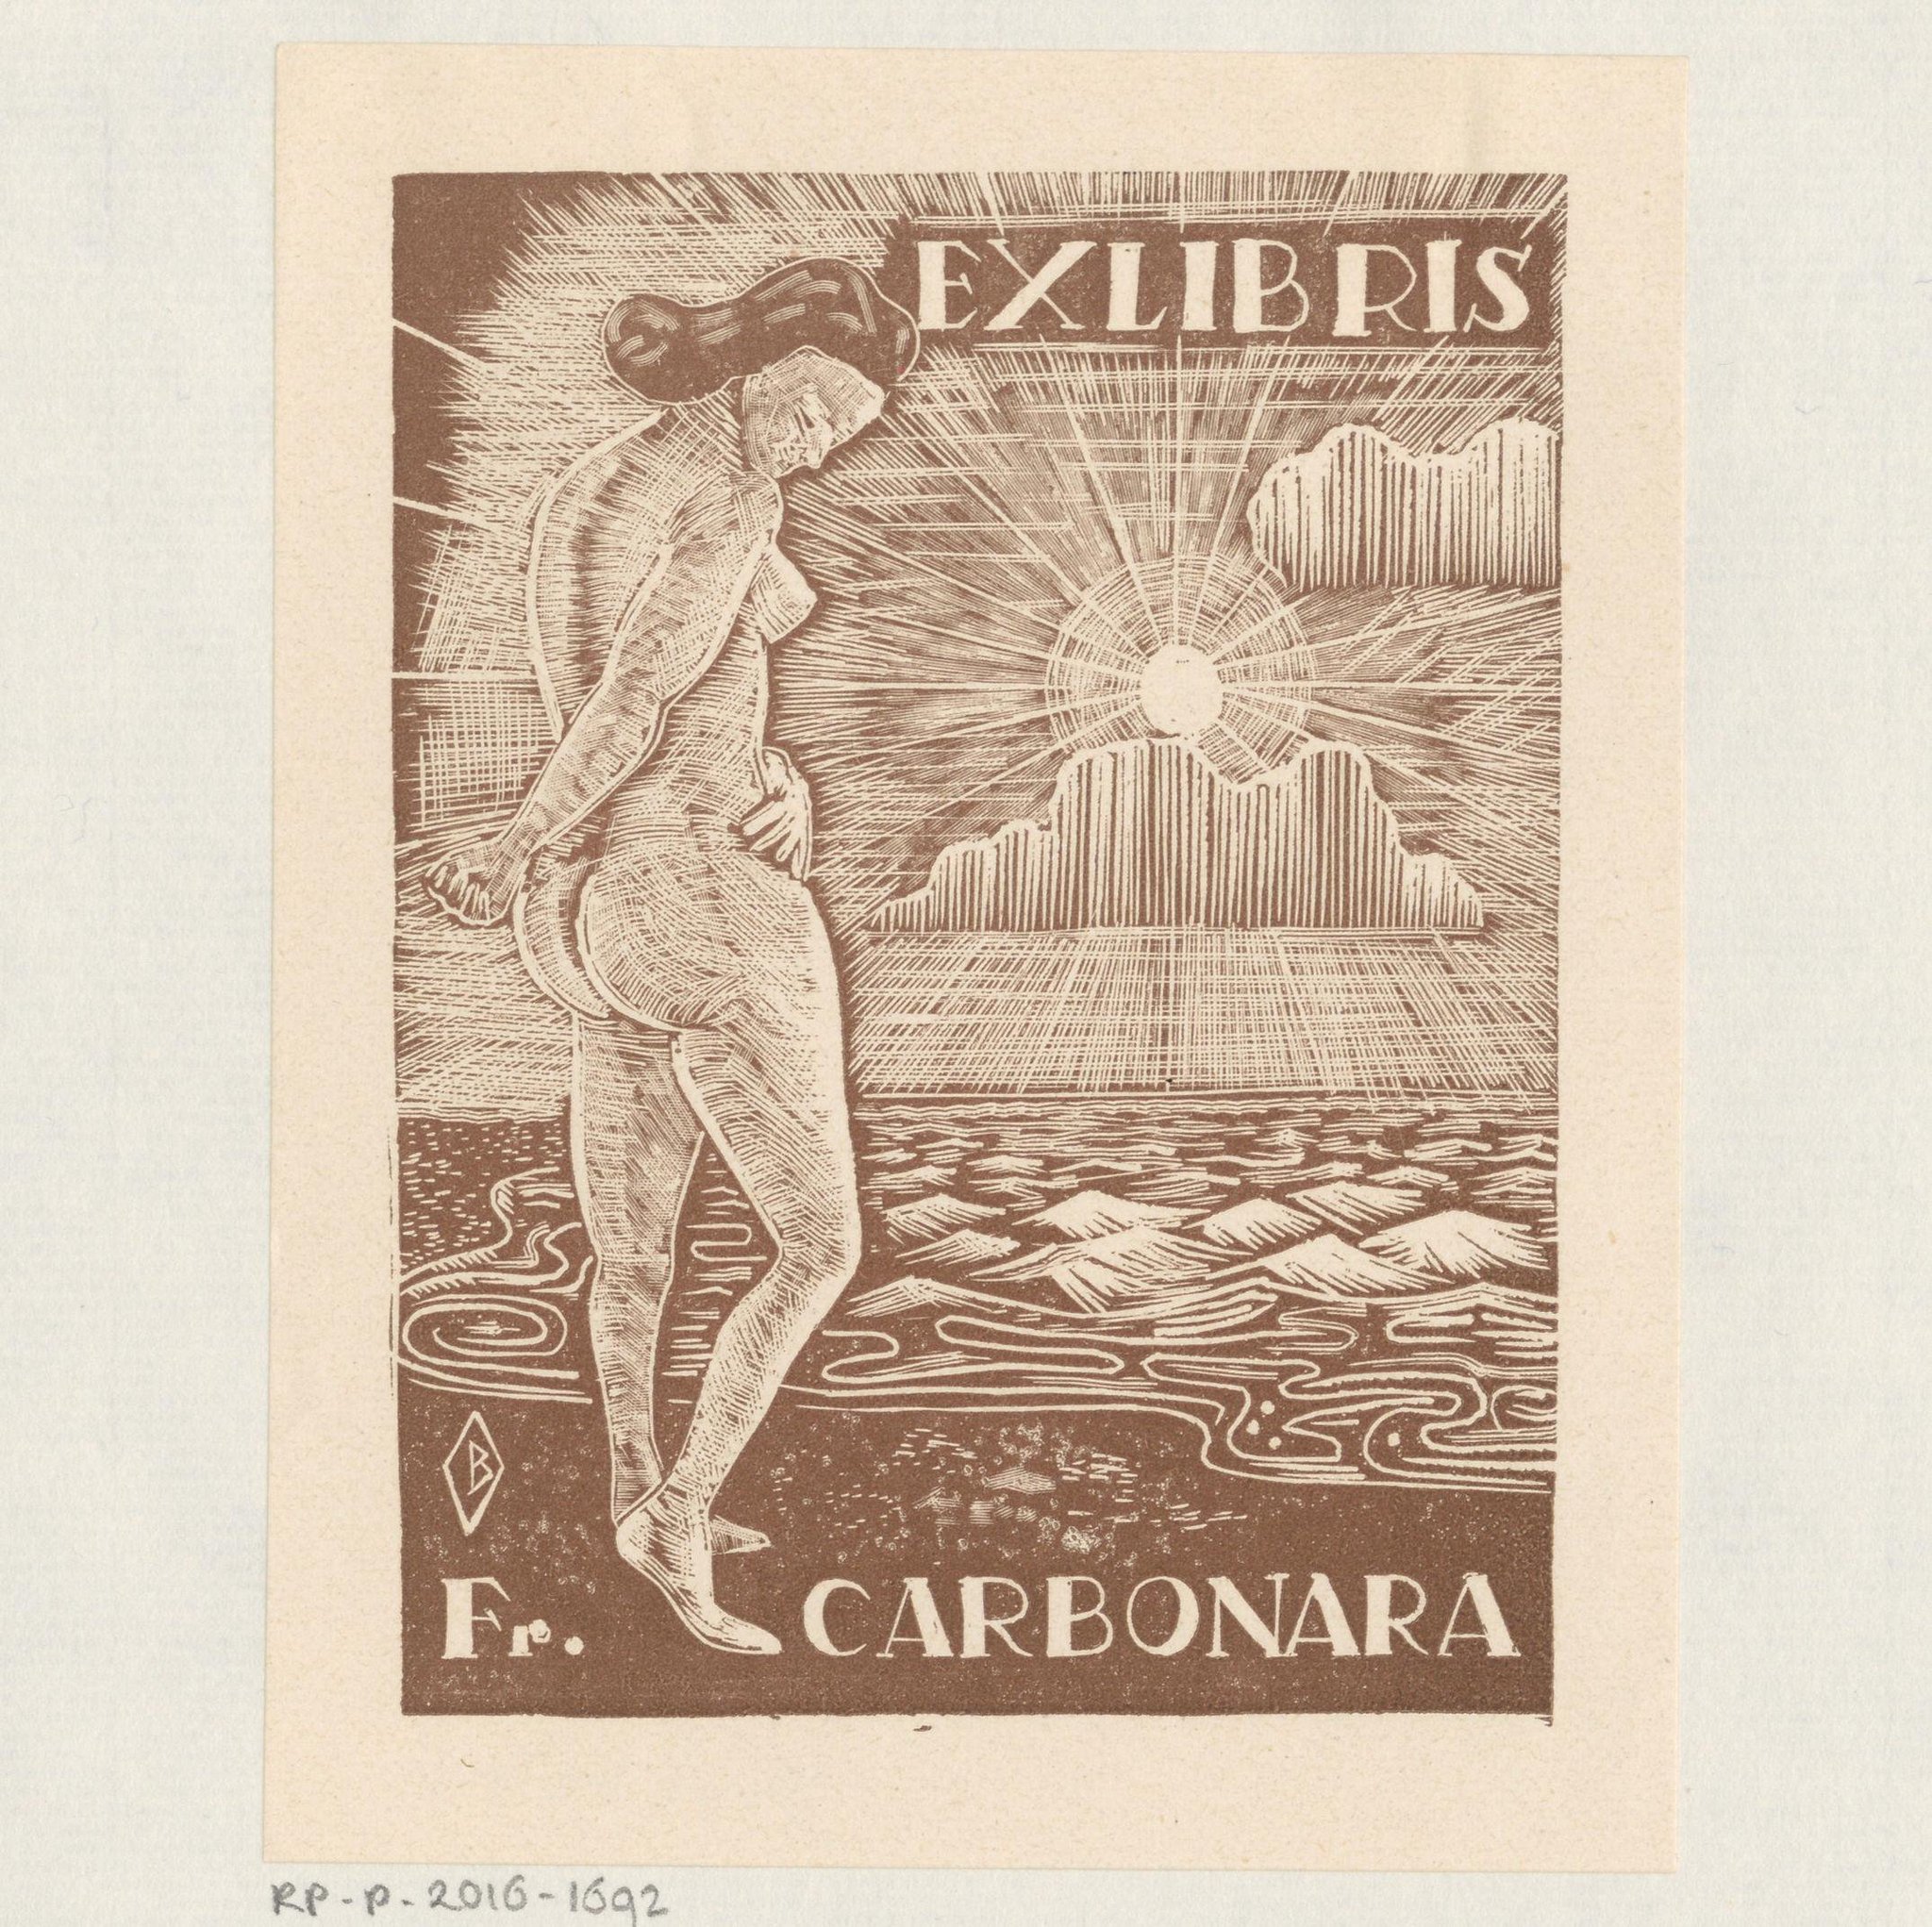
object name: bookplate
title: Ex libris van Francesco Carbonara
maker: theo broekstra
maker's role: print maker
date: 1950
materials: paper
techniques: engraving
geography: netherlands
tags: woman (showing herself) undressed, quasi-nude, sea (seascape), sunset